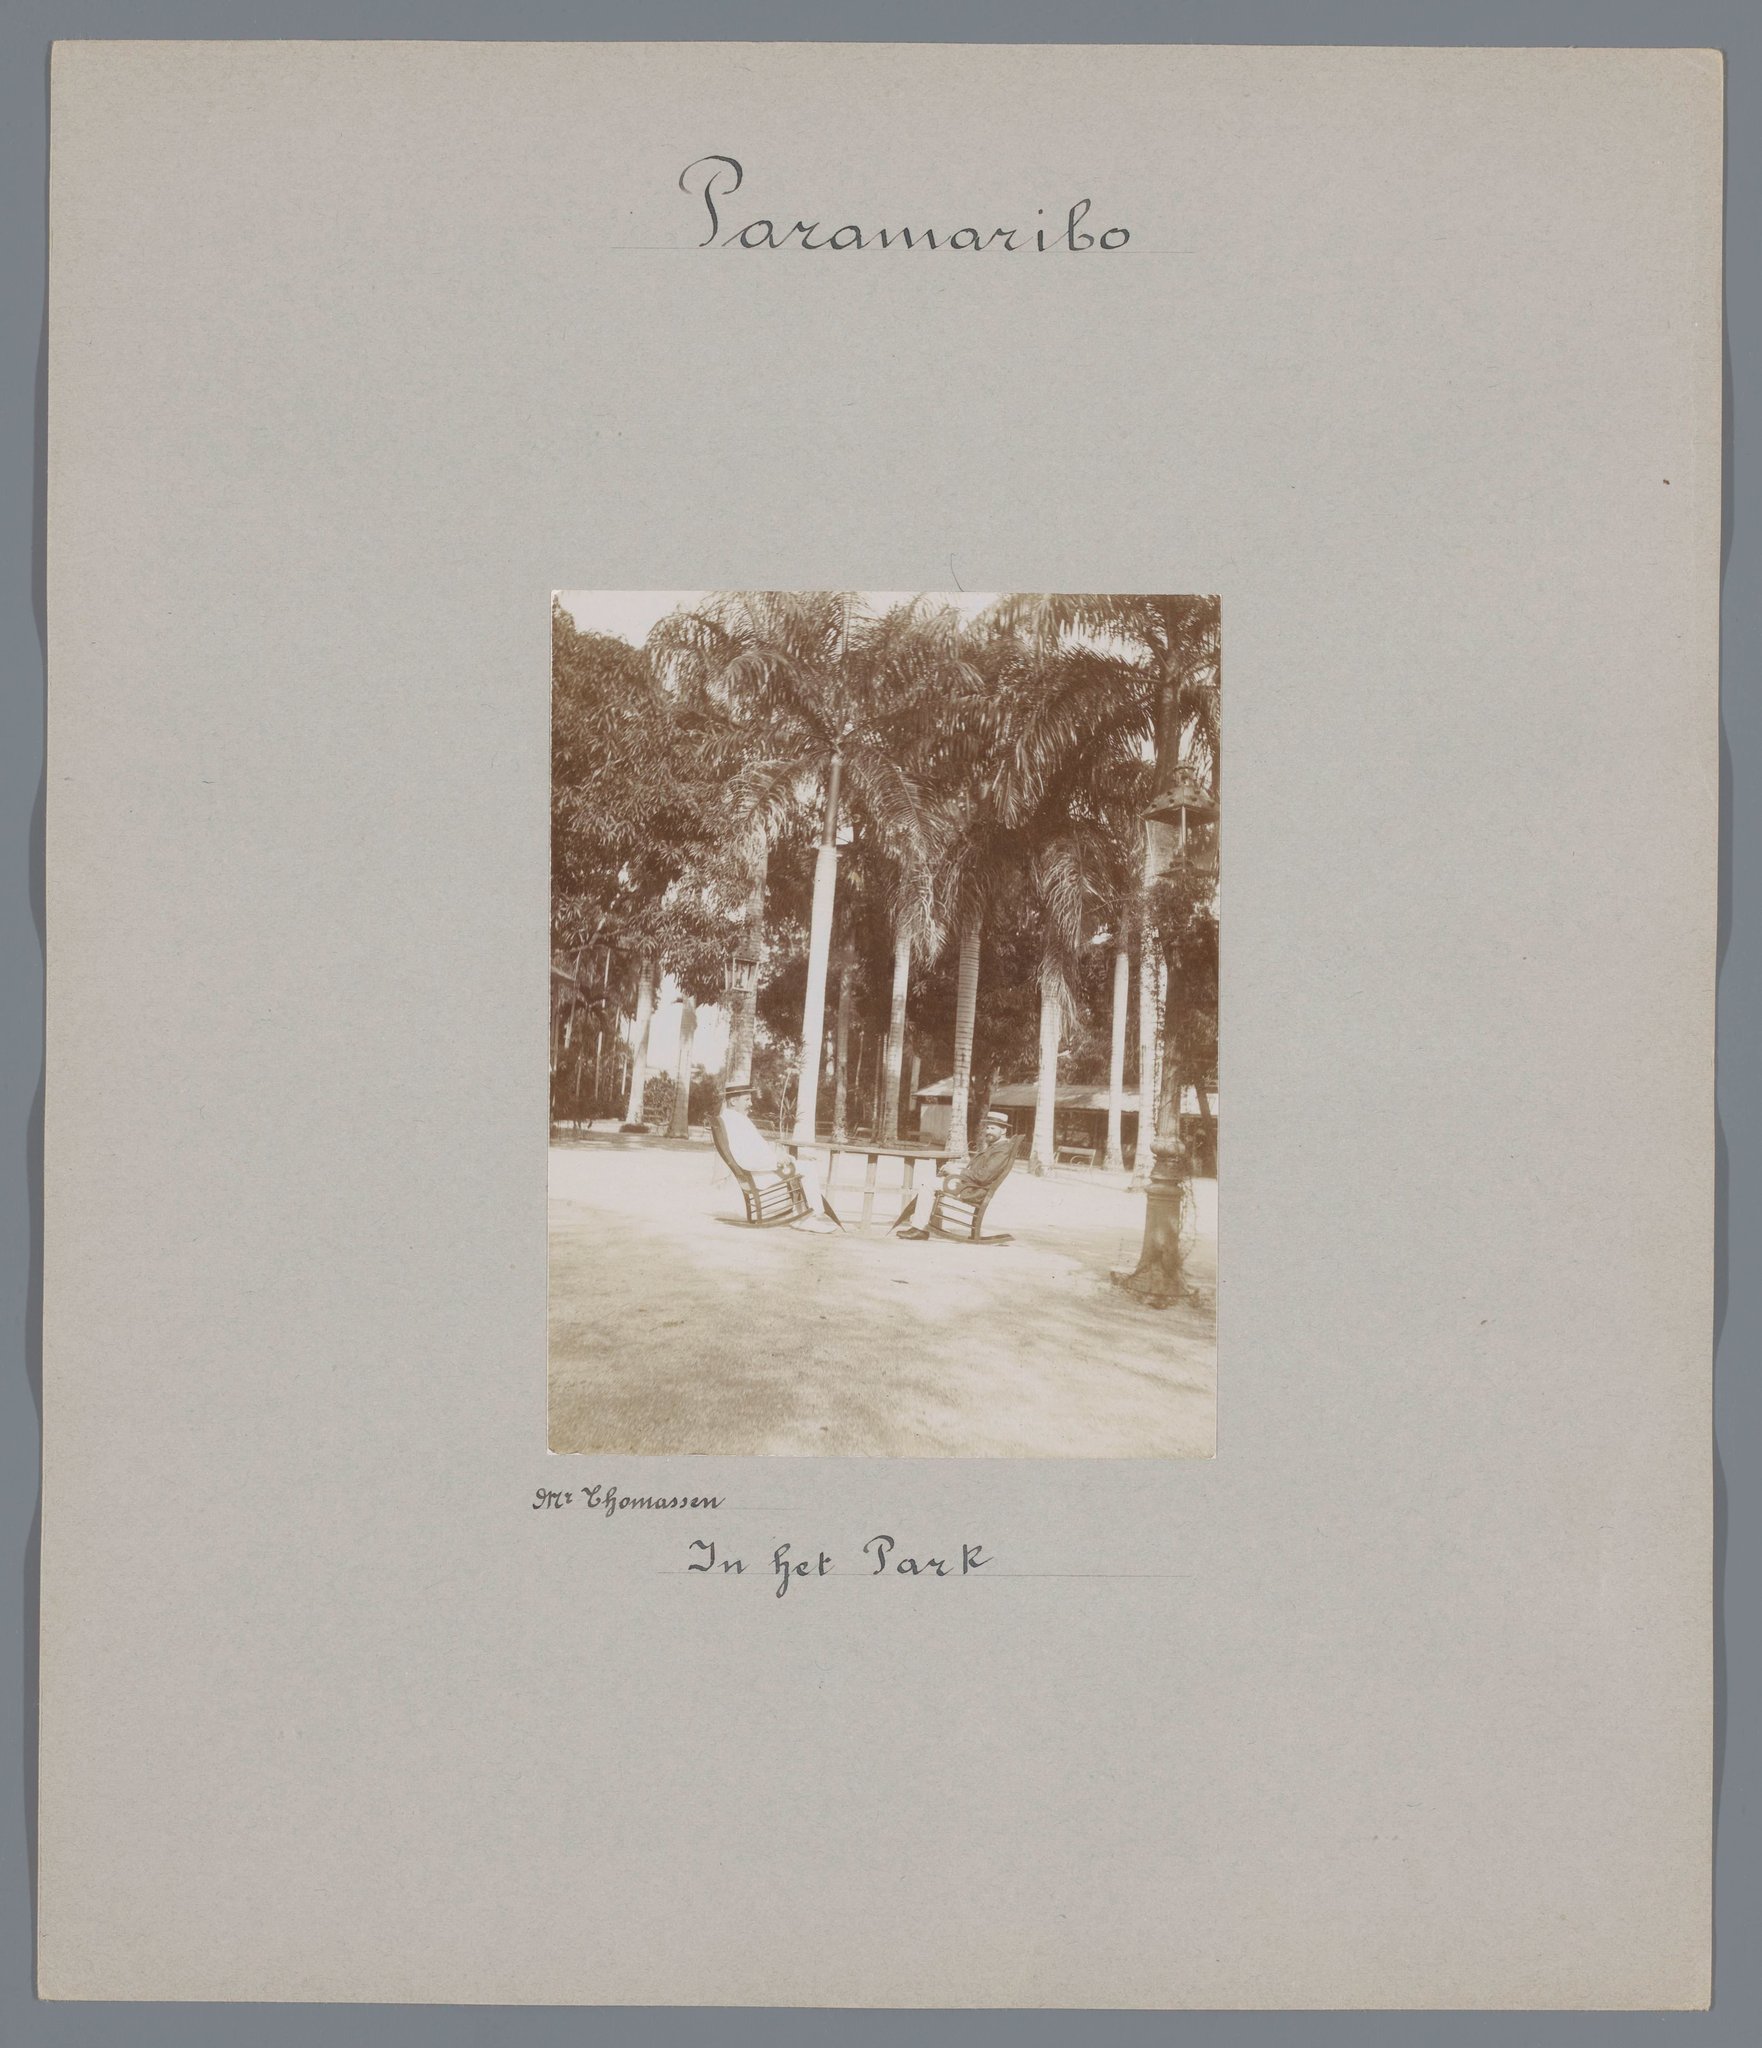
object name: photograph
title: In het Park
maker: eugen klein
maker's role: fotograaf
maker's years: 1869-1927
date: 1900-1905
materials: cardboard, photographic support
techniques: gelatin silver print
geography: paramaribo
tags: het park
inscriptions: inscription: ‘Paramaribo / In het Park / Mr Thomassen’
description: Twee mannen zittend aan een tafeltje op het terras van de buitensociëteit Het Park te Paramaribo. De man links wordt in het opschrift geïdentificeerd als Mr. Thomassen. Onderdeel van een groep van 44 foto's van Paramaribo, Suriname en Curaçao, ca. 1900-1905, opgeplakt op kartons en voorzien van opschriften.